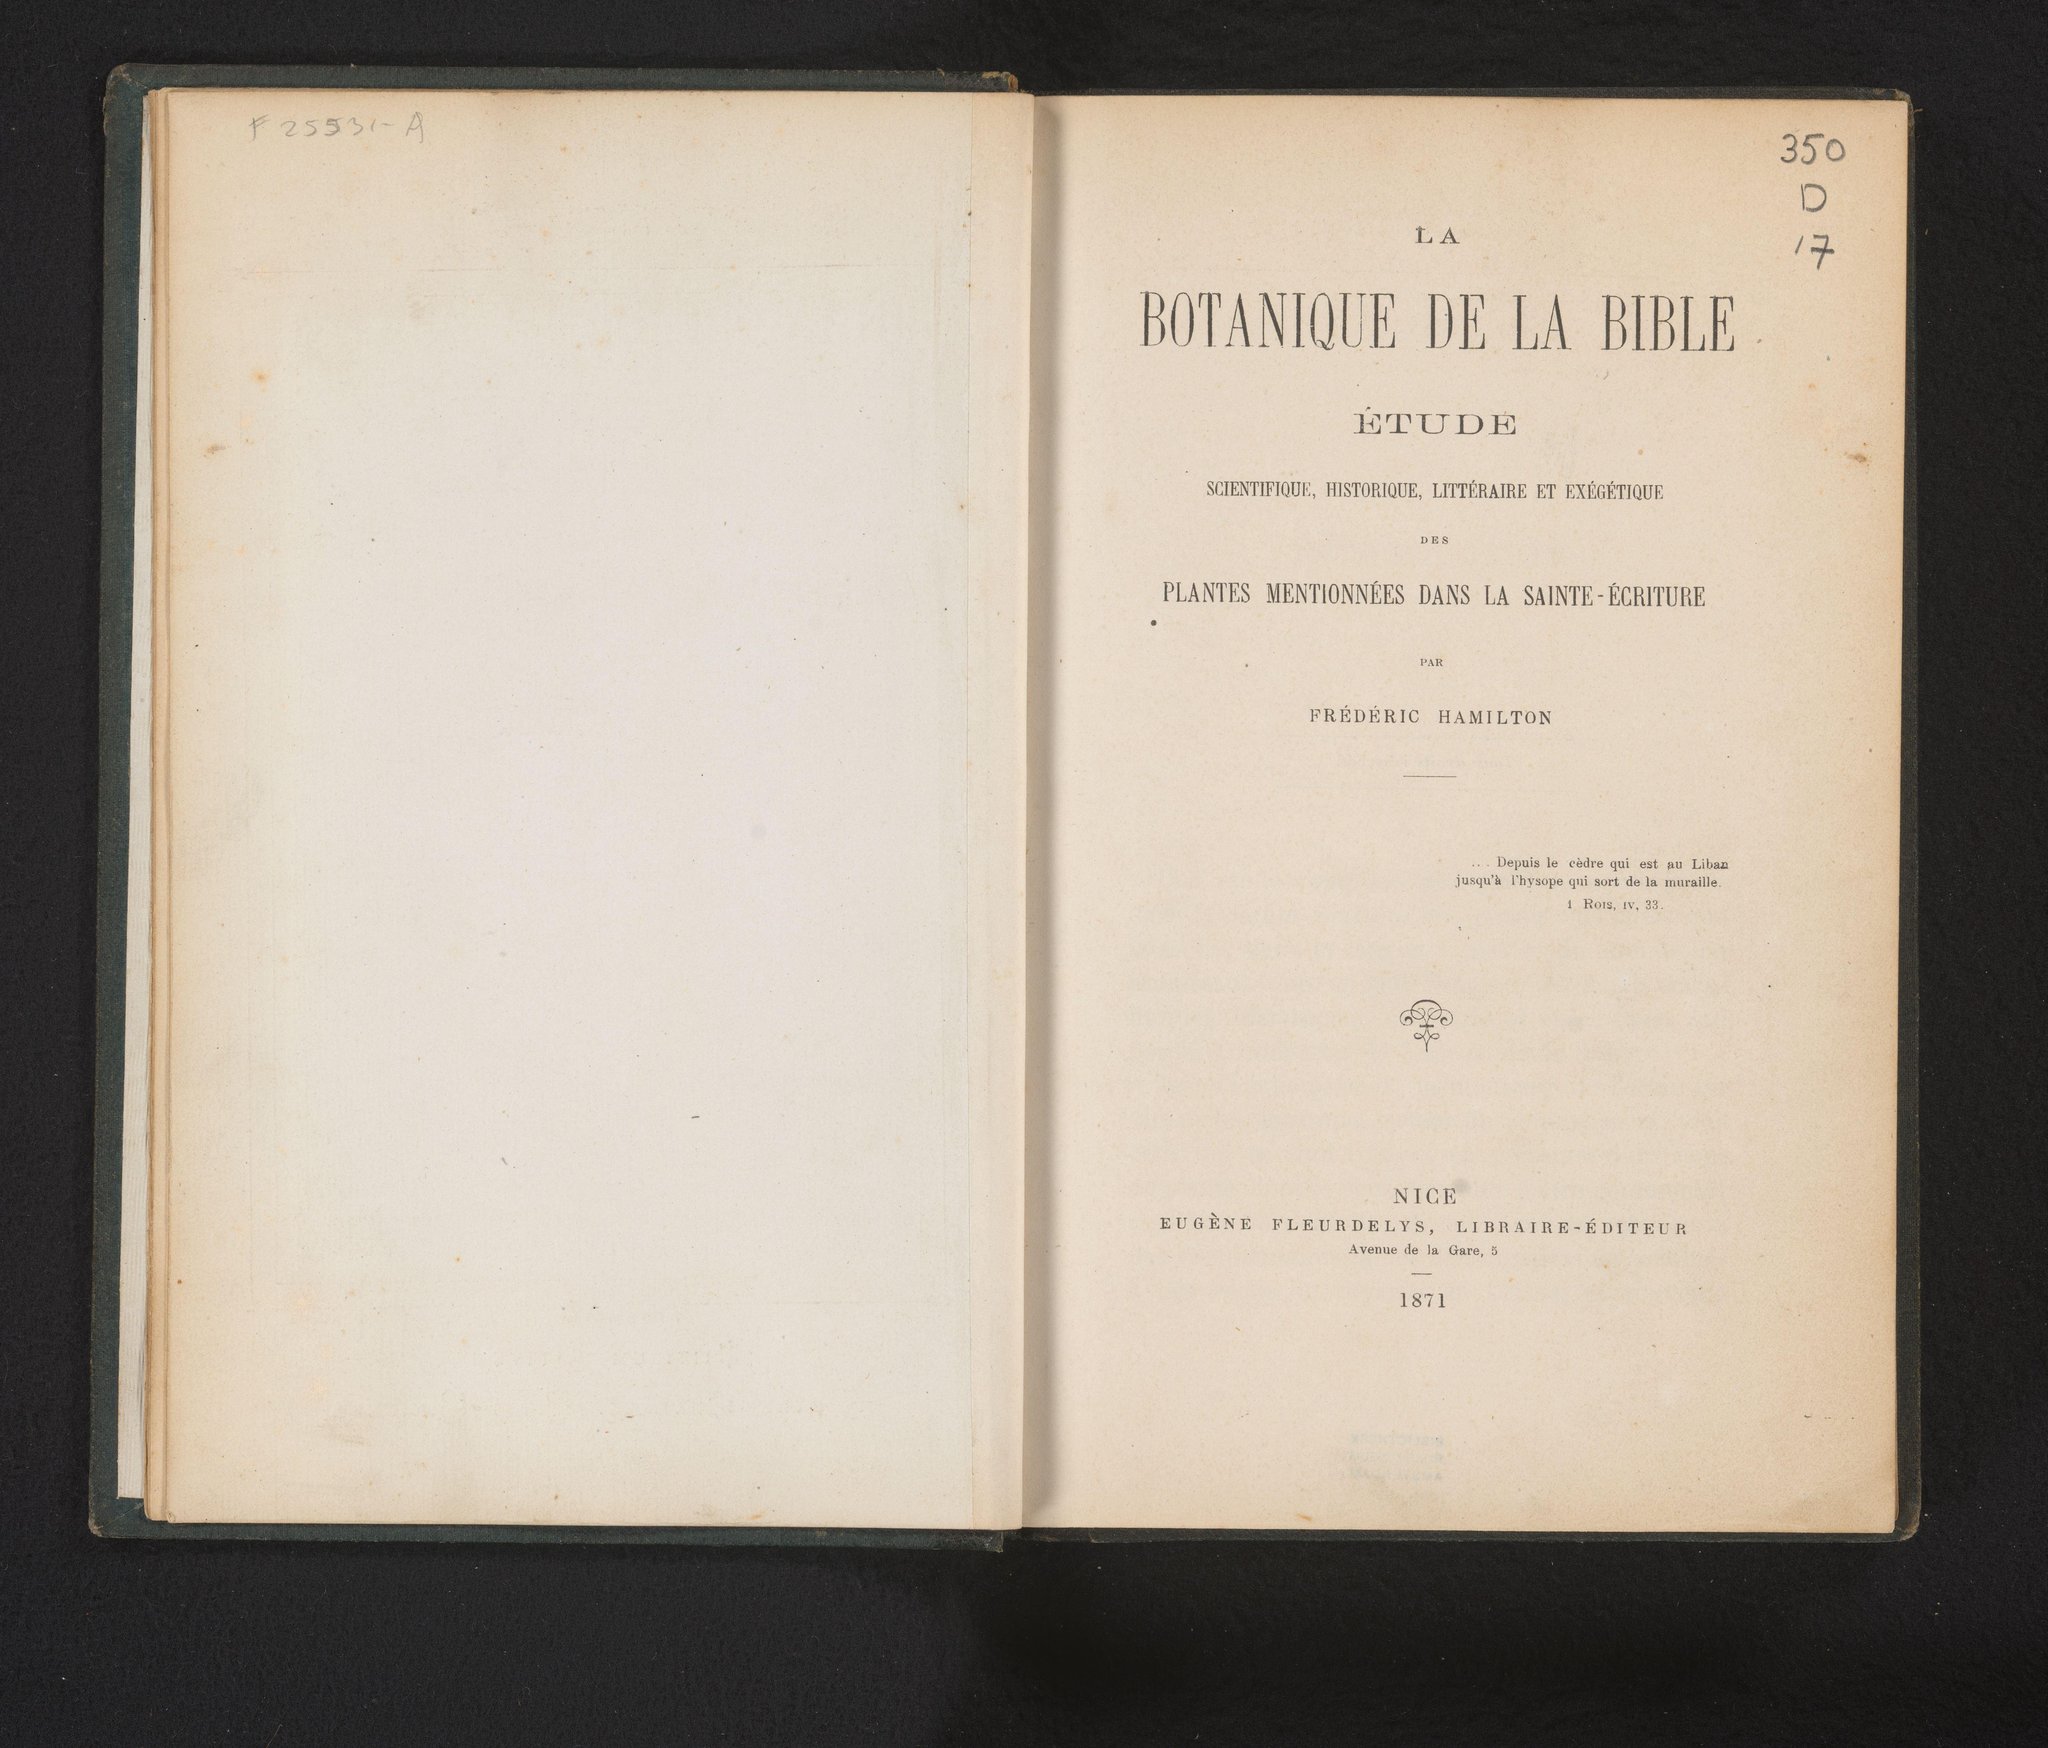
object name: book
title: La botanique de la Bible : étude scientifique, historique, littéraire, exégétique des plantes mentionnées dans la Sainte-Écriture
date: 1871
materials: cardboard, linen, paper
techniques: albumen print, letterpress printing, moire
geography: nice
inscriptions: collector's mark: ‘BIBLIOTHEEK/ RIJKSMUSEUM/ AMSTERDAM’